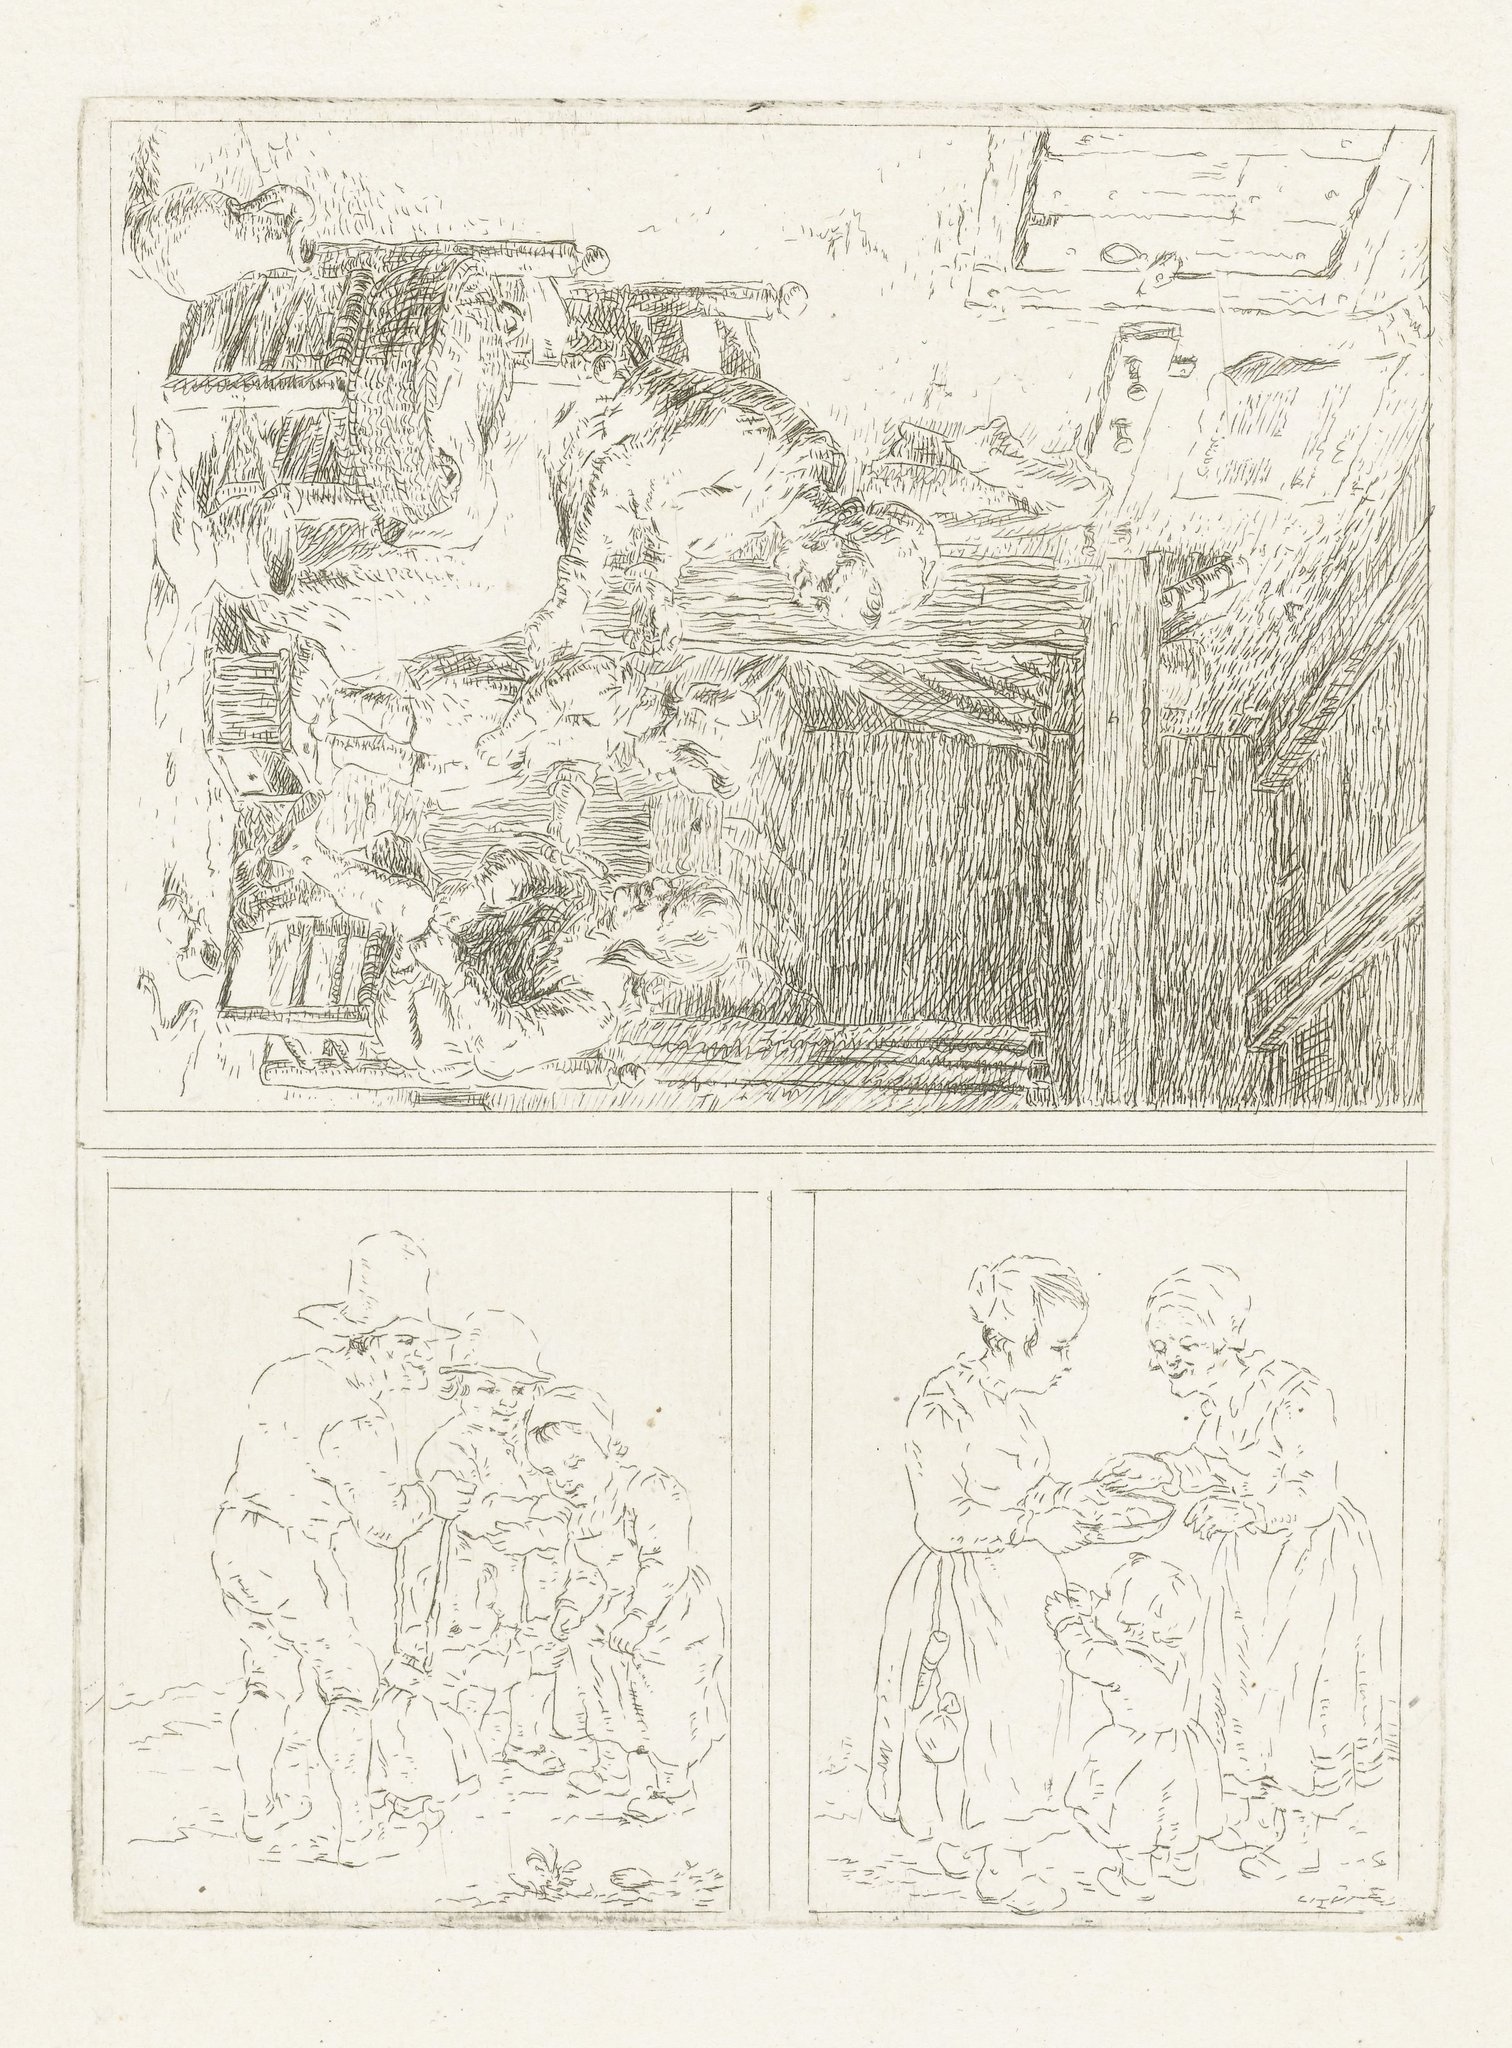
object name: print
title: Drie voorstellingen van het gezinsleven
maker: christina chalon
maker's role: draughtsman, print maker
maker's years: 1748-1808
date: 1758-1808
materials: paper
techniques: etching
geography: leiden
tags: dressing oneself, getting dressed, child(ren) with one or both parents and one or more members of the preceding generation (family group), implements for learning to walk, go-cart, mother and child(ren), woman and child(ren) (family group) (with number of children), learning to walk, the first steps, dressing oneself, getting dressed - aa - female human figure, bedroom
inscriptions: collector's mark: Lugt 2228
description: Eerste voorstelling speelt zich af in het interieur van een slaapkamer. Een moeder helpt haar kinderen bij het ochtendtoilet. Ze vetert het jurkje van haar dochter. Haar zoontje trekt ondertussen zijn kousen aan. In de tweede voorstelling praat een jonge vrouw met een oudere vrouw. De jongere vrouw heeft een pan in beide handen. Een klein kind staat voor haar. In de derde voorstelling leert een oude man een peuter lopen door middel van een leiband en een tuigje. Moeder en vader lokken het kind naar hen toe.